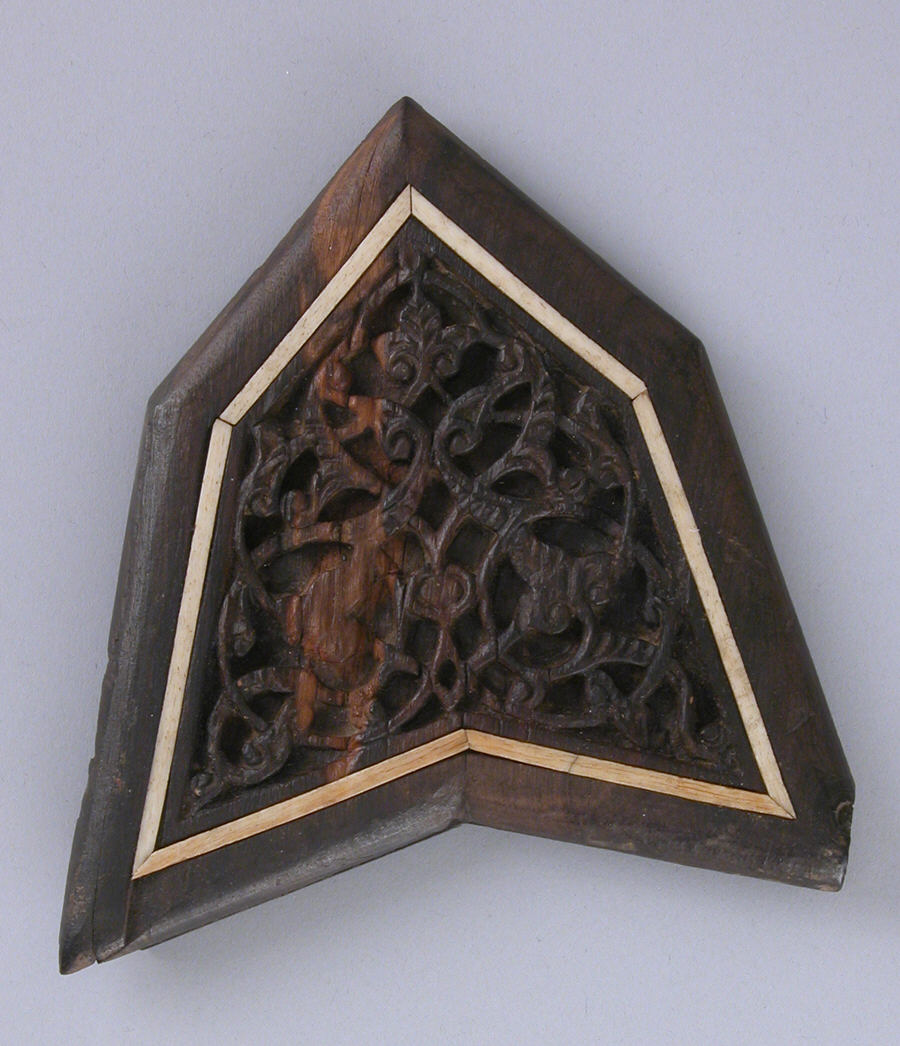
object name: panel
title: Panel from a Minbar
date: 1201-1400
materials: ivory, paint, wood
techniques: carving, inlay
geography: egypt